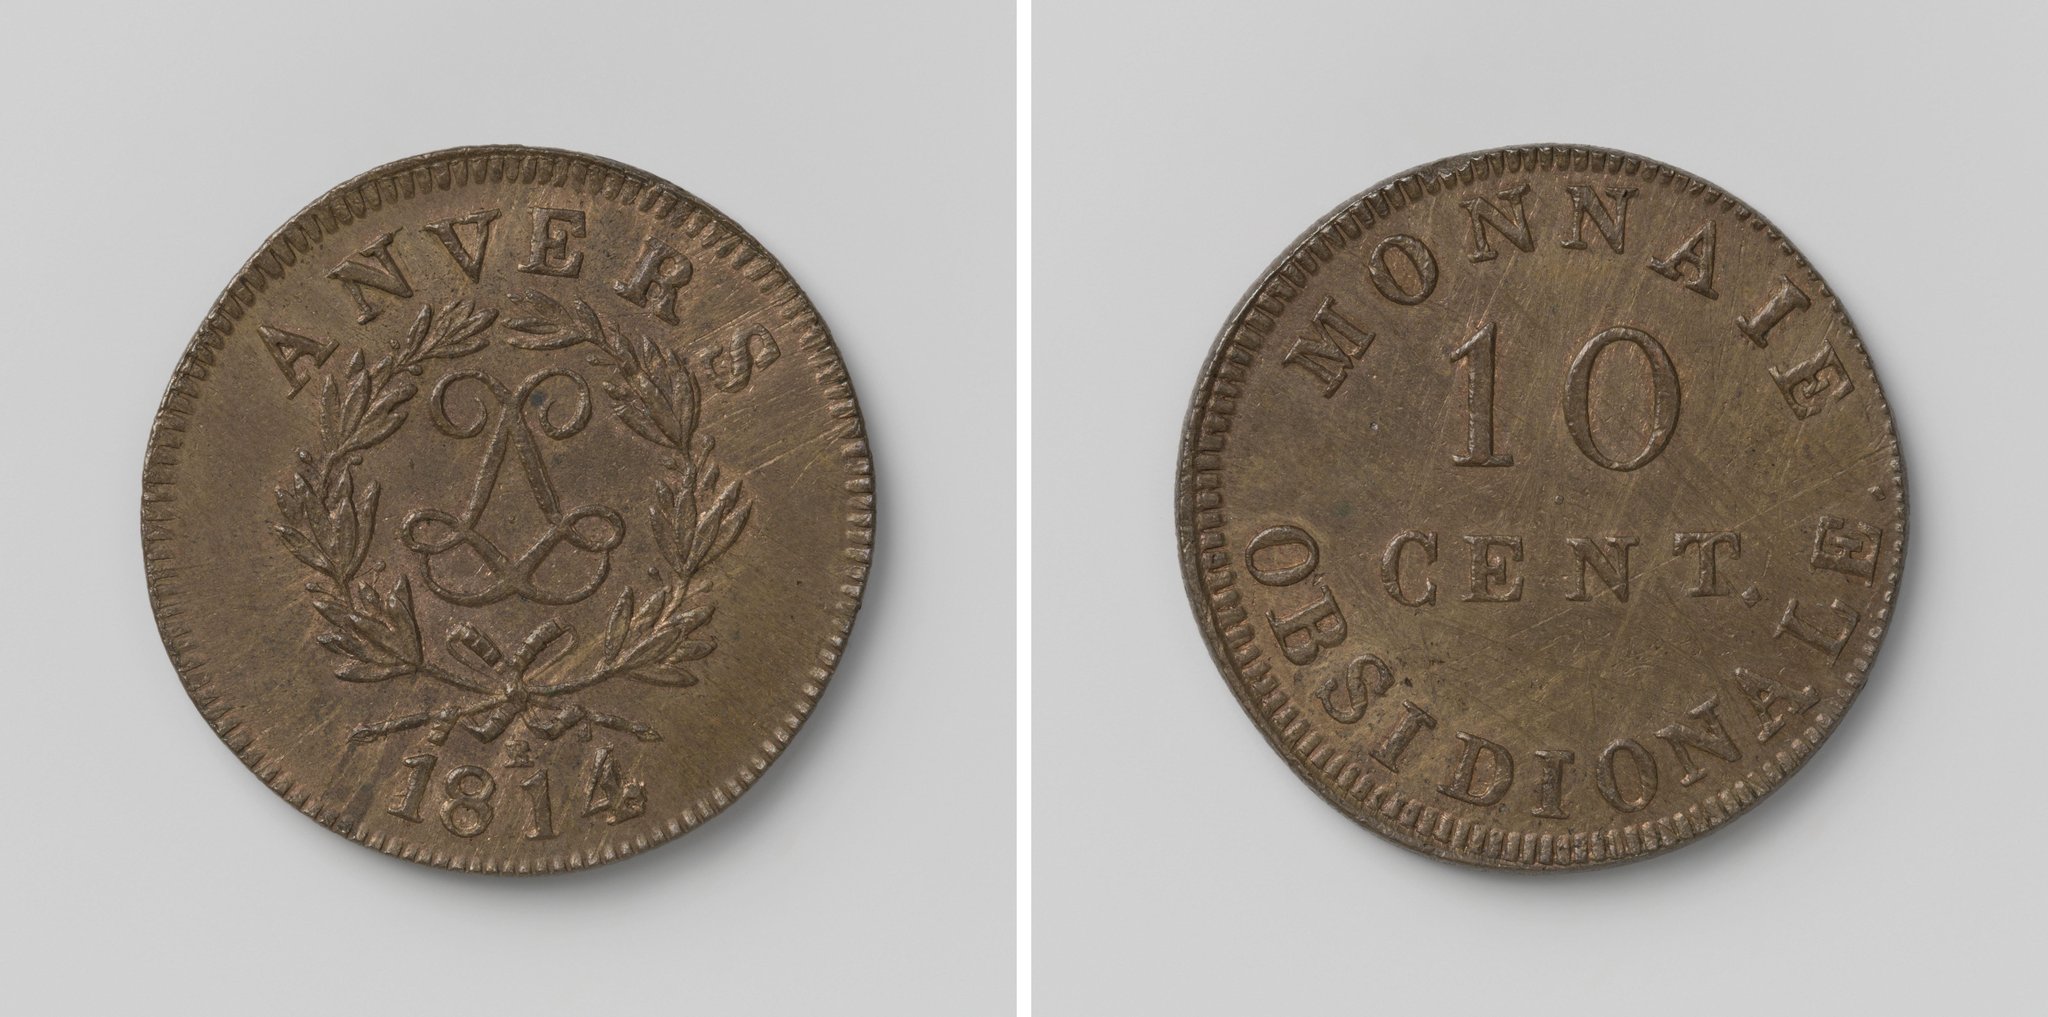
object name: tien cent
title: Beleg van Antwerpen, noodmunt van tien cent, geslagen door Lodewijk XVIII, koning van Frankrijk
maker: Anonymous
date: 1814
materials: copper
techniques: striking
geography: antwerp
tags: lodewijk xviii (koning van frankrijk), antwerp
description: Koperen noodmunt. Voorzijde:twee letters L binnen lauwerkrans onder opschrift boven jaartal; onder lauwerkrans:letter R. Keerzijde:waardeaanduiding binnen omschrift